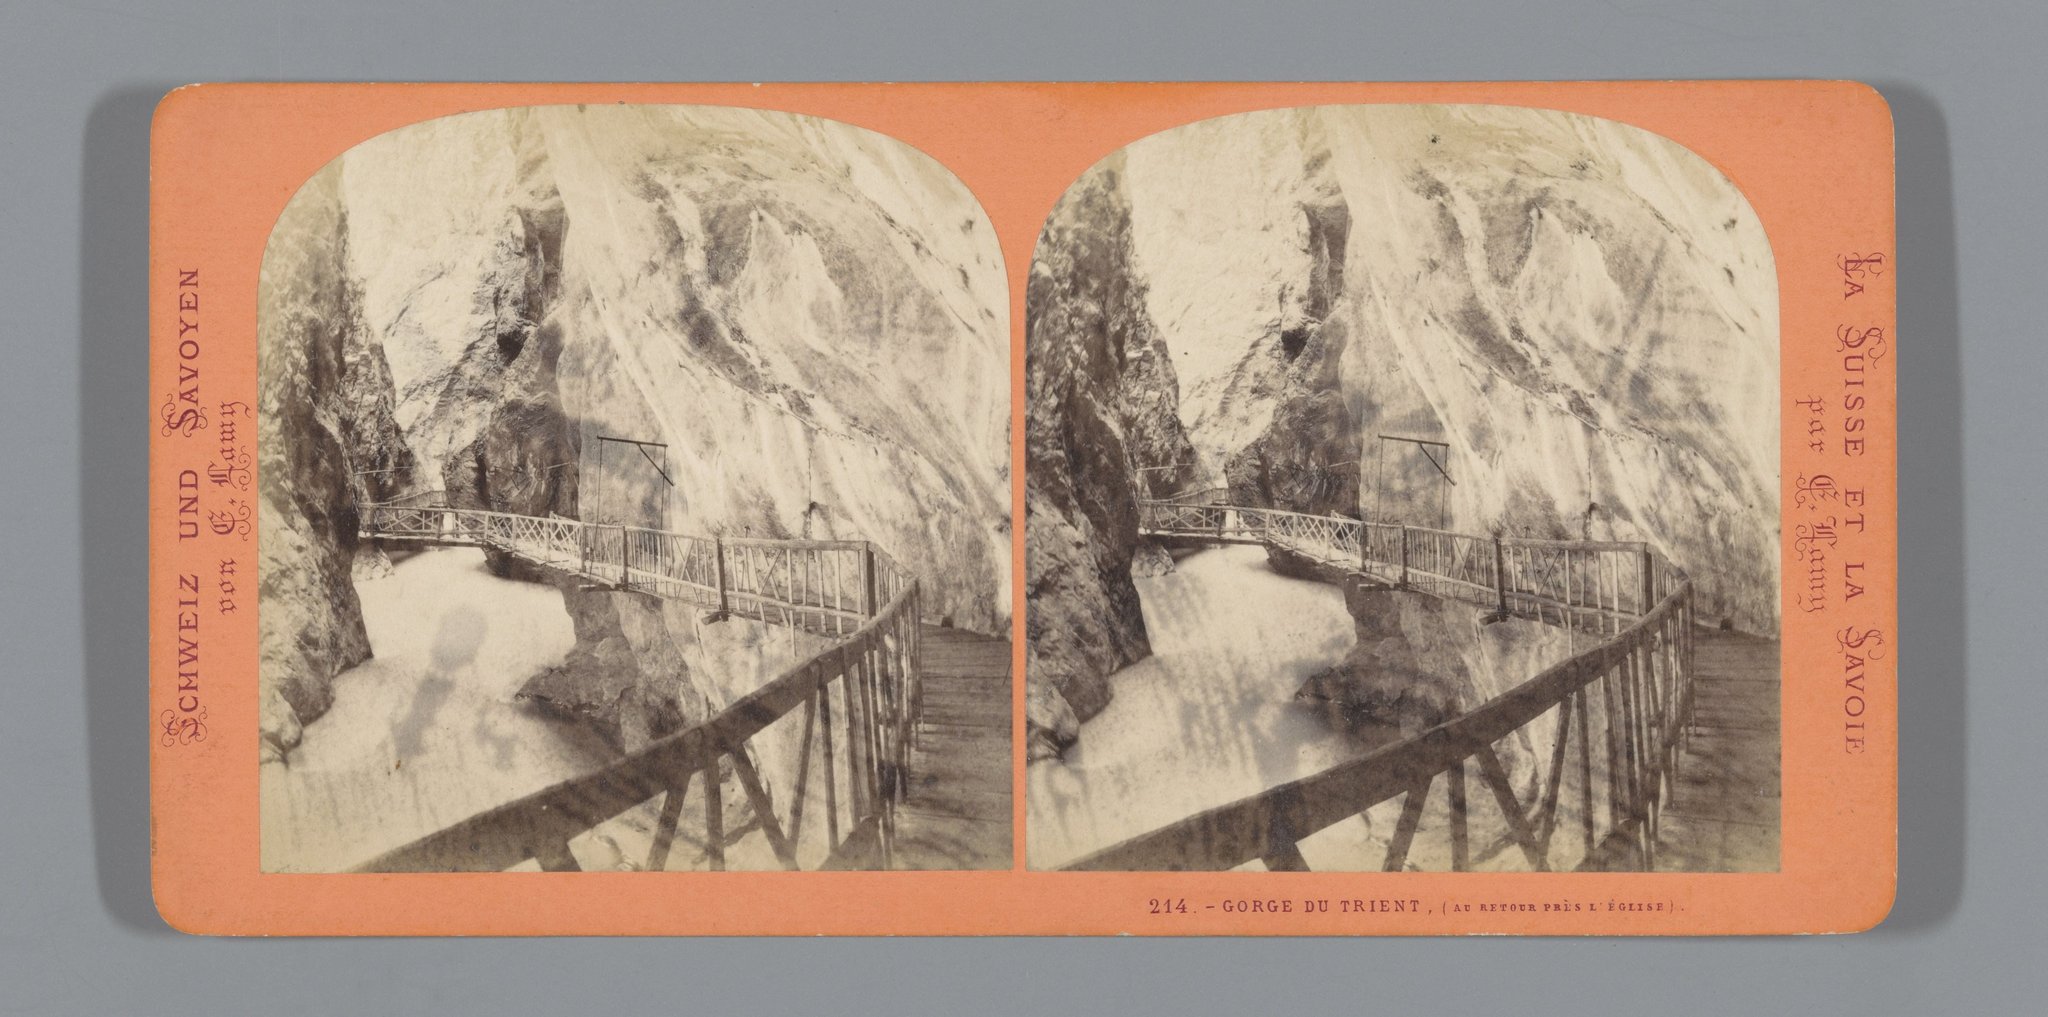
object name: stereograph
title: Looppad langs de Gorges du Trient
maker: ernest eléonor pierre lamy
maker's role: publisher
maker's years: 1828-1900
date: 1860-1880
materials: cardboard, photographic support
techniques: albumen print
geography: switzerland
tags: ravine, chasm, abyss, canyon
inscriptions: number: ‘214.’